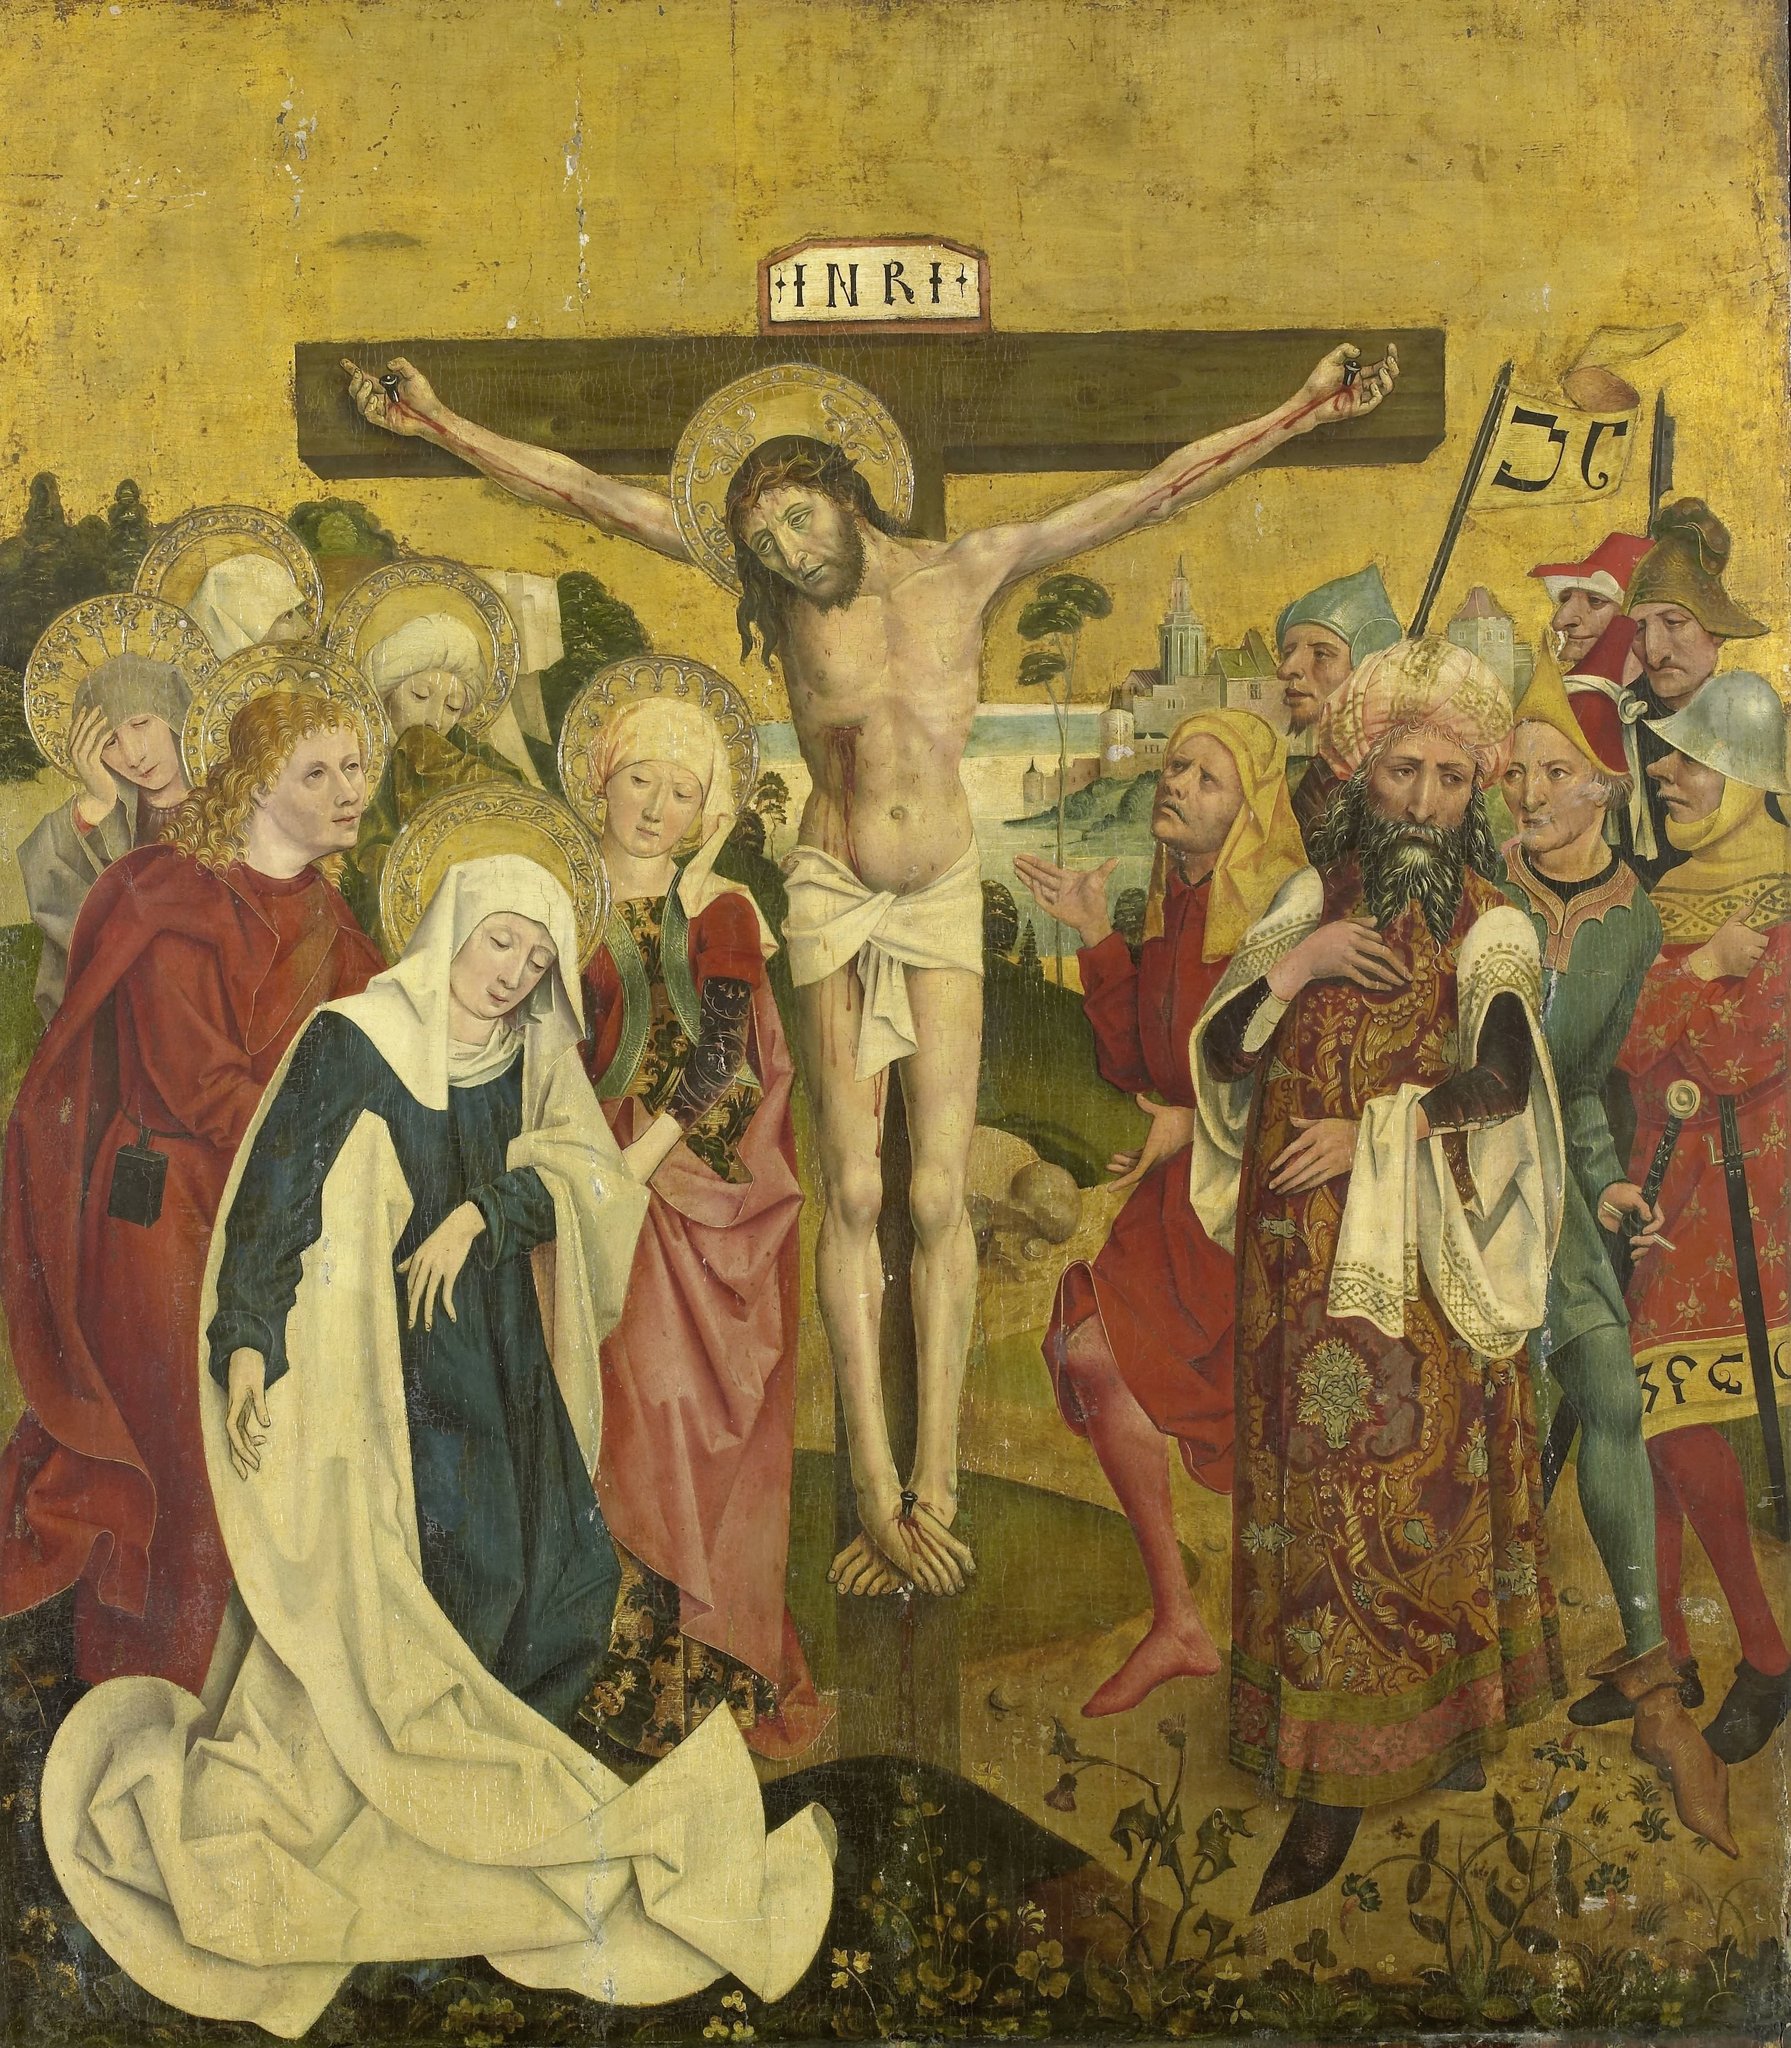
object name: painting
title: Crucifixion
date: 1475-1500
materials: oil, panel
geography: germany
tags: comprehensive representations of the events on golgotha during christ's hanging on the cross, no particular event emphasized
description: Kruisiging. Christus aan het kruis, links Maria die in zwijm valt, Johannes, Maria Magdalena en de heilige vrouwen, rechts Pilatus en soldaten. Onderdeel van een groot altaarstuk uit het voormalige Augustinerchorherrenstift Rottenbuch. Drie van de andere panelen bevinden zich in de collectie van de Bayerische Staatsgemäldesammlungen te München (tentoongesteld in de Staatsgalerie Burghausen im Palas der Burg). Een ander paneel bevindt zich in het Musée Grobet-Labadié in Marseille, en wederom vier andere in privébezit.